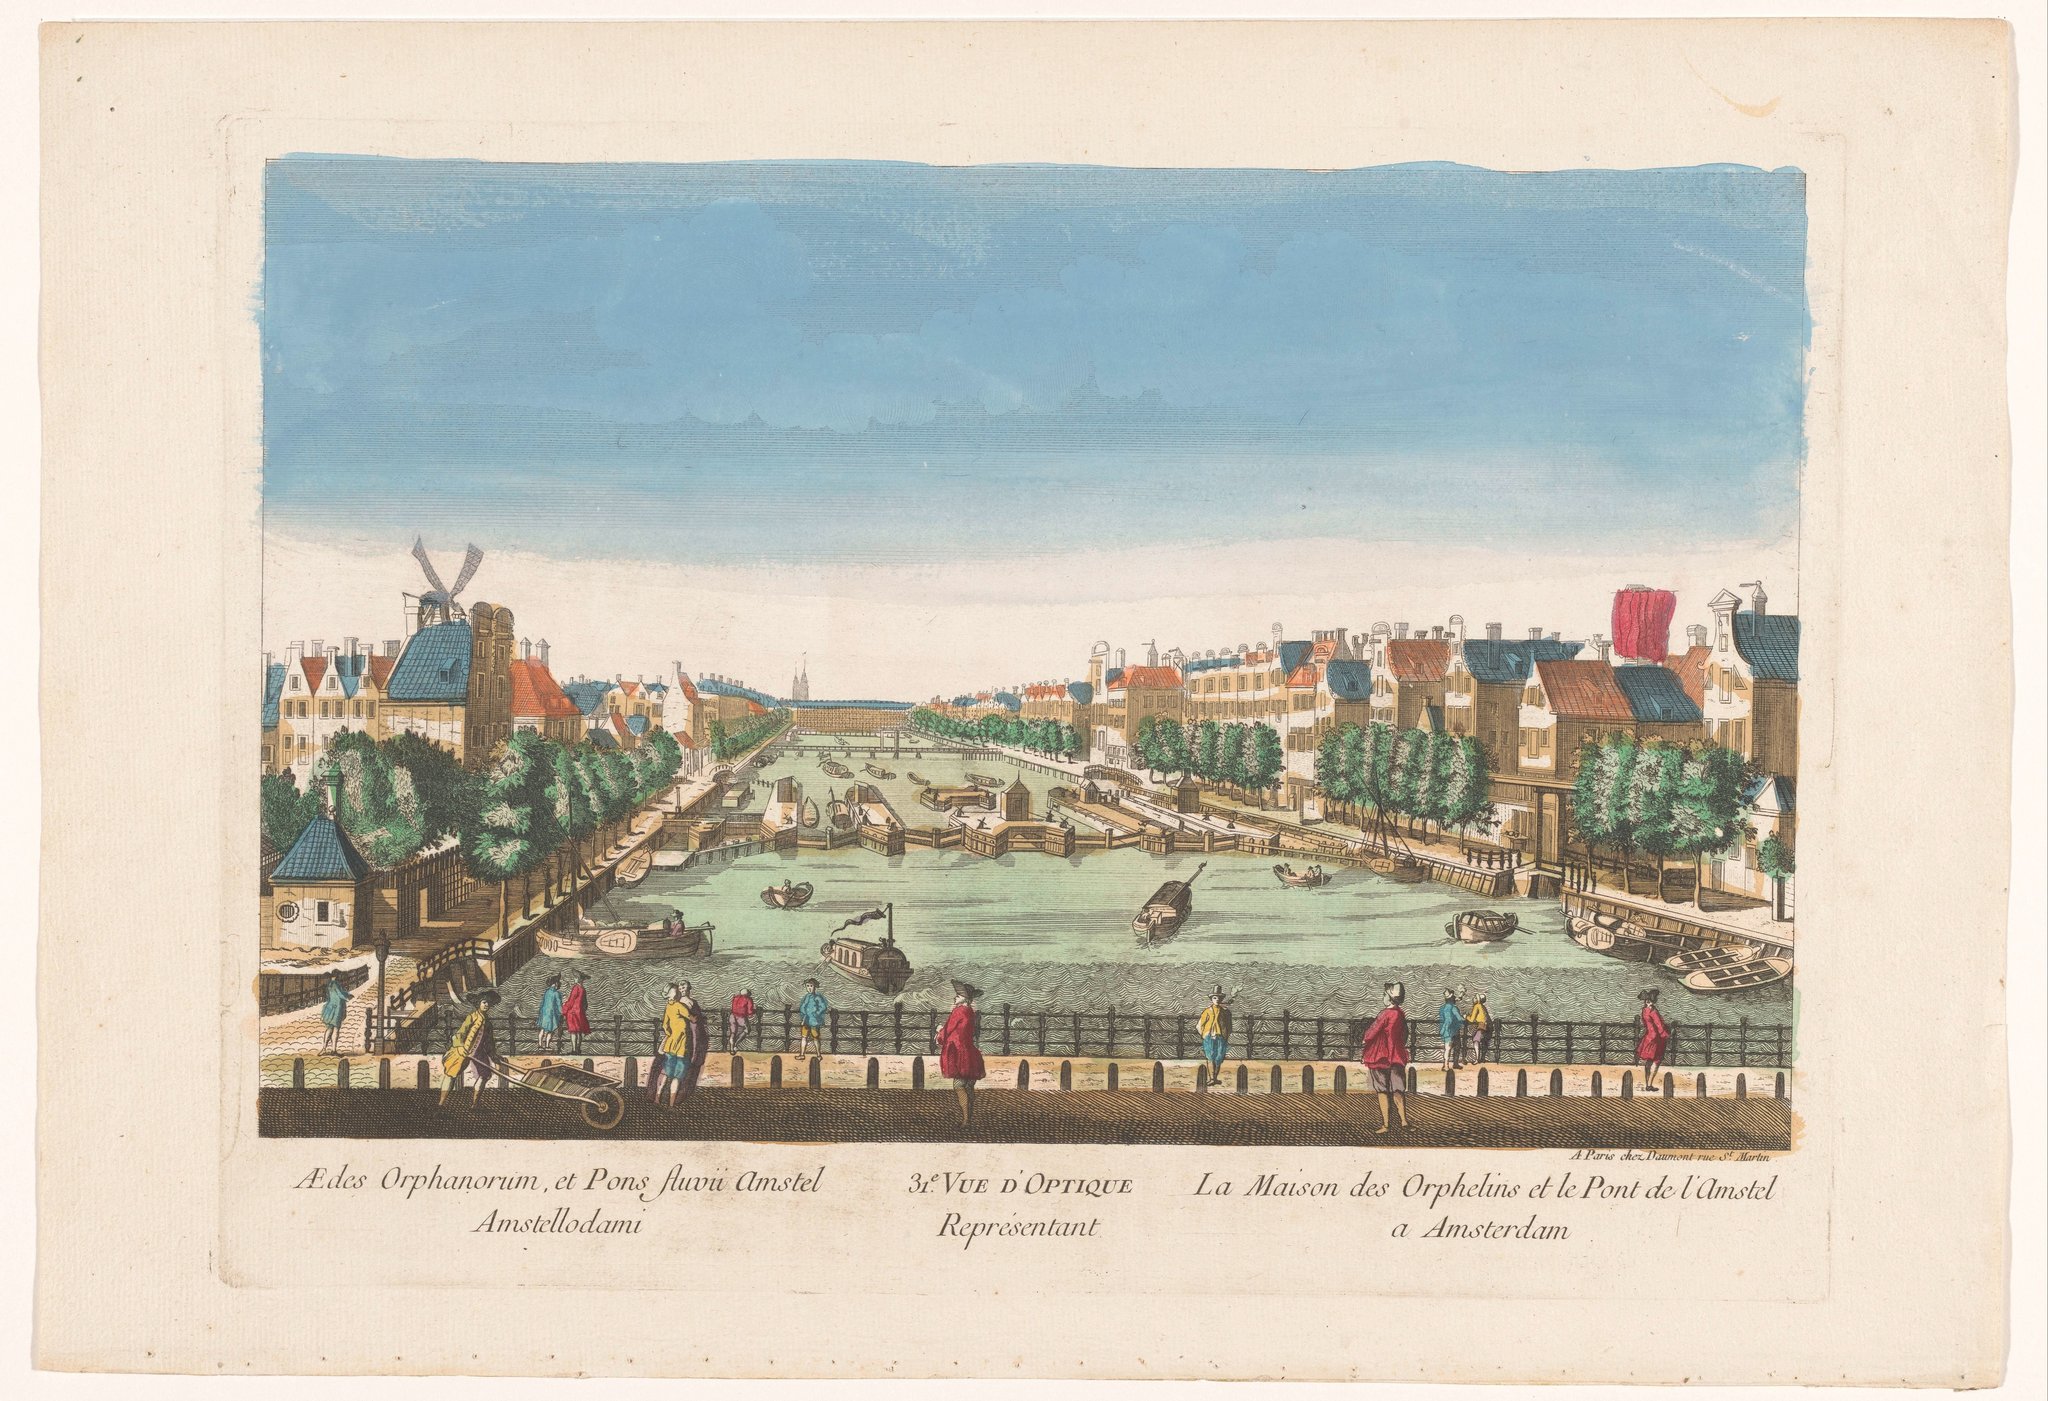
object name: print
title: Gezicht op de Amstelsluis en het Diaconieweeshuis te Amsterdam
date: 1745-1775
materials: paper, watercolor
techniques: brush, etching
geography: paris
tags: sluice, weir, bridge in city across river, canal, etc. (+ city(-scape) with figures, staffage), orphanage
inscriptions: watermark, collector's mark: Lugt 2166